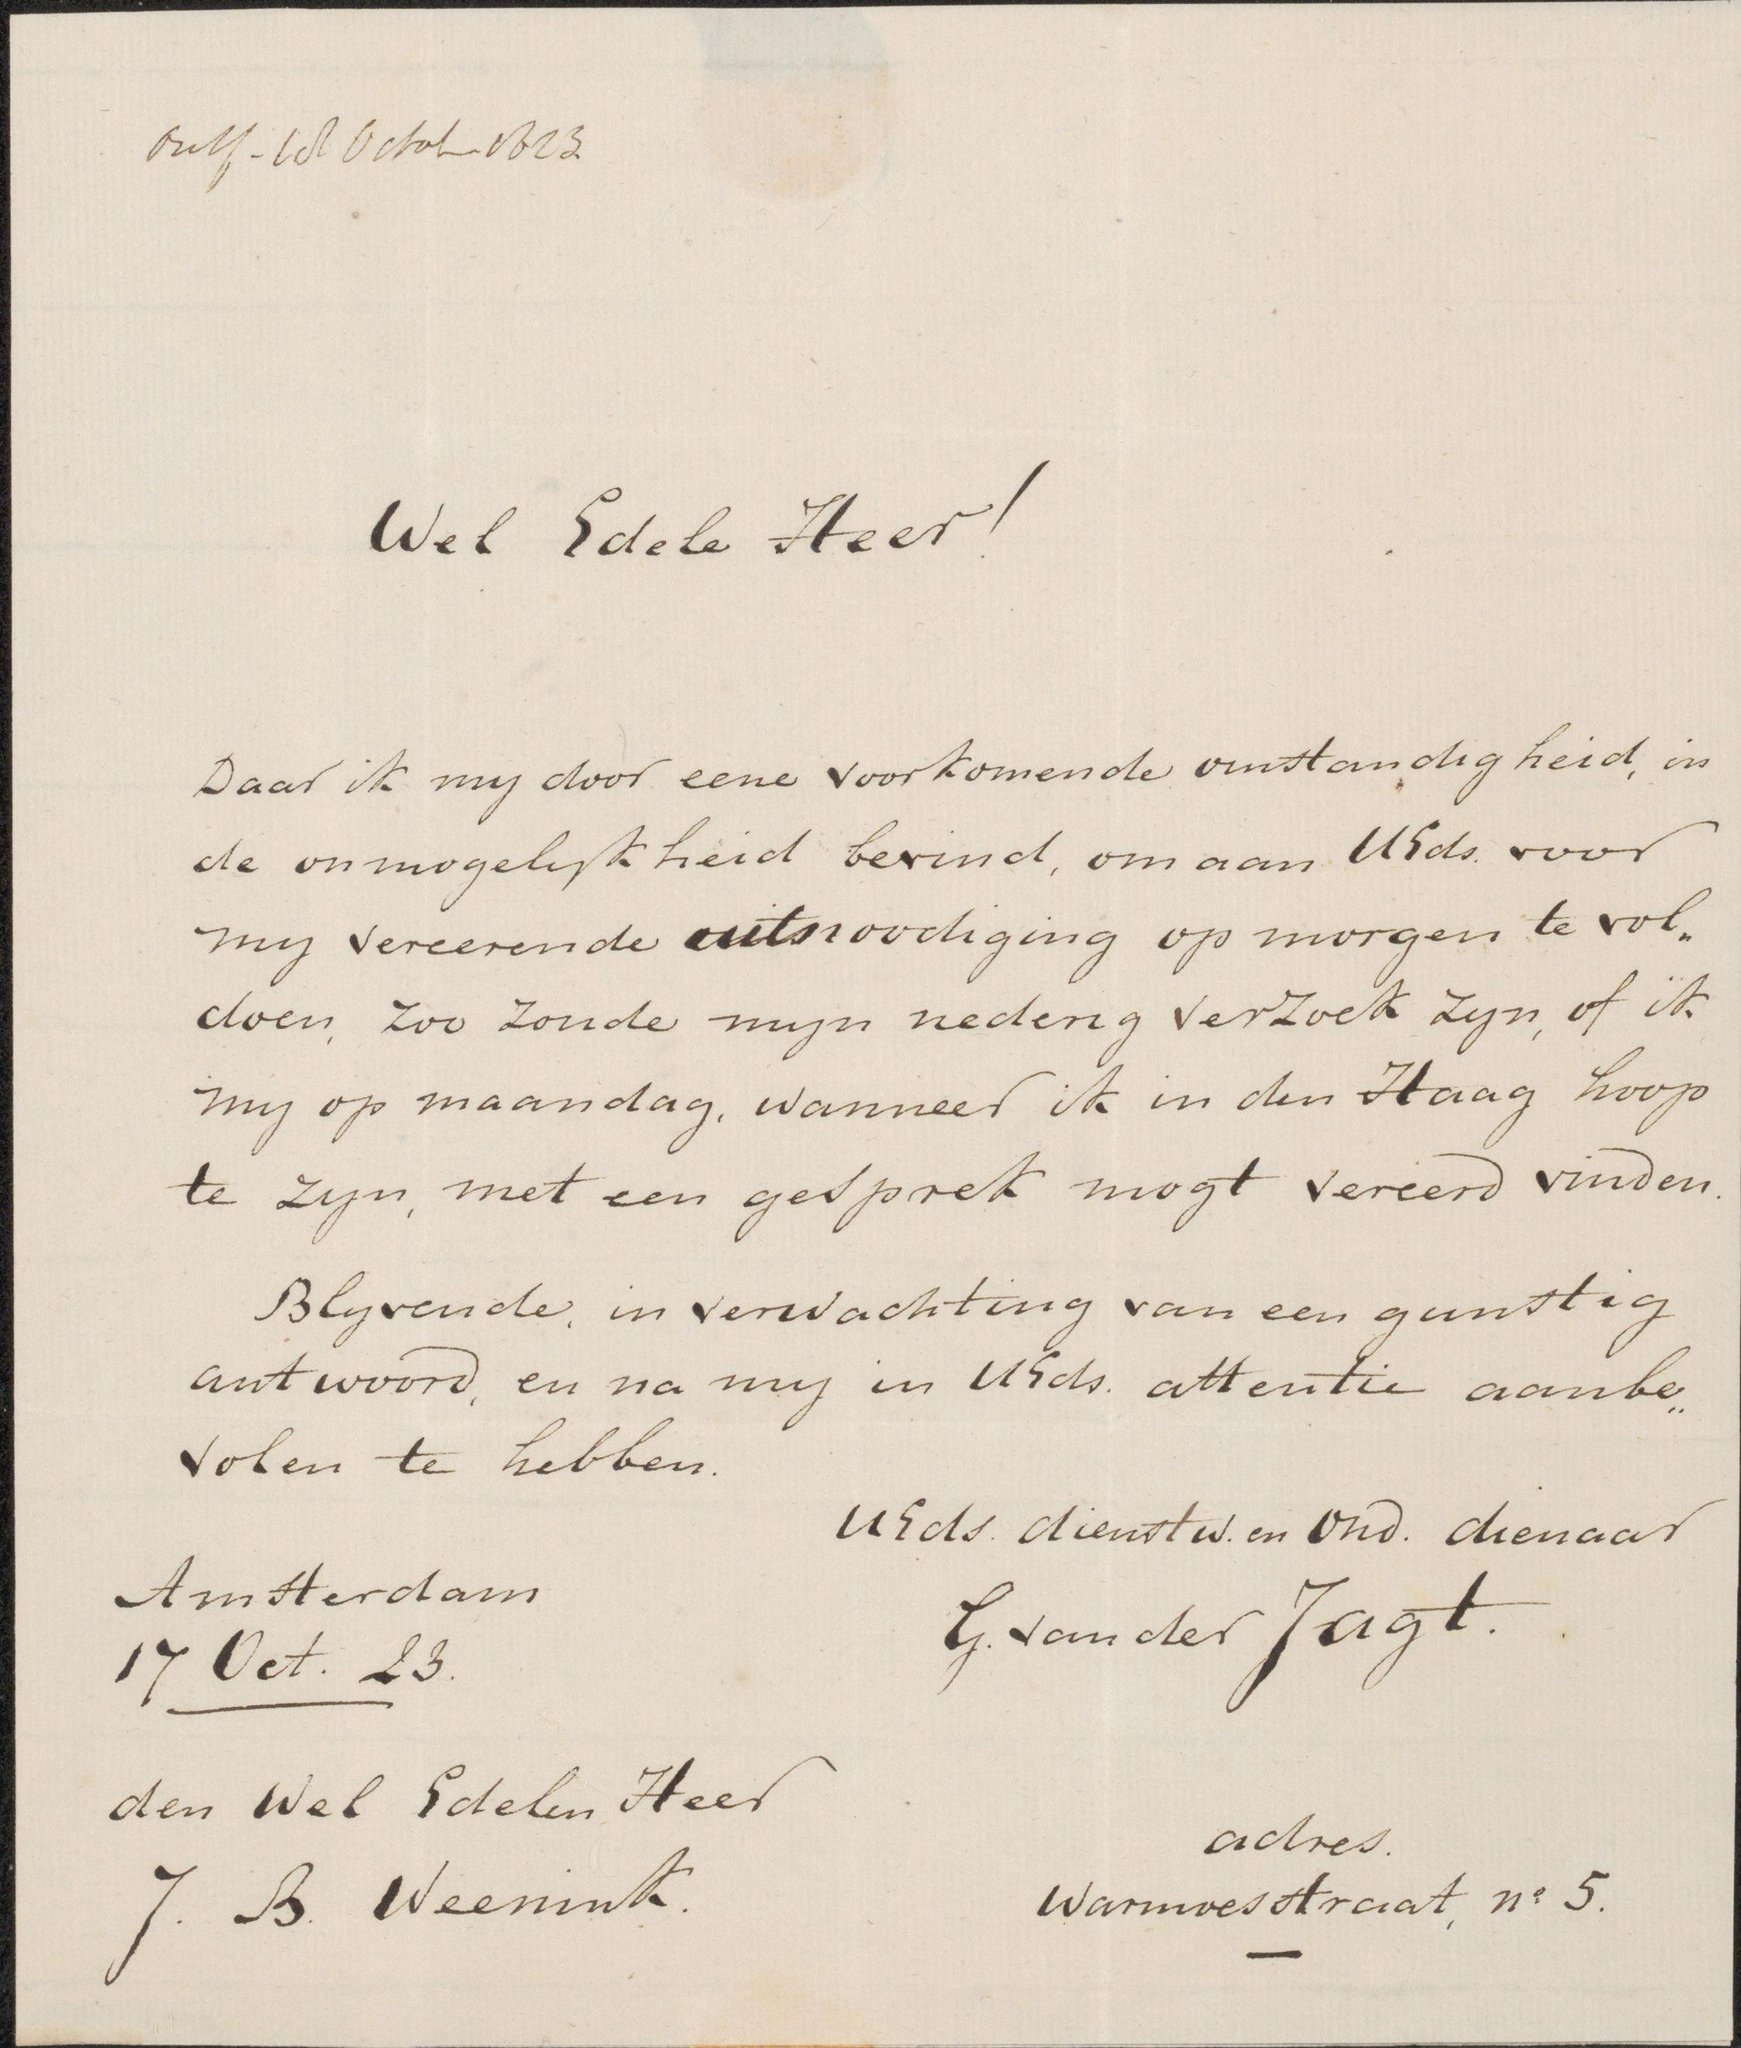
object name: letter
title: Brief aan Jean Baptiste Weenink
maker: gijsbert van der jagt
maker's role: directeur, onderwijzer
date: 1823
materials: ink, paper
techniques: pen, writing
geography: amsterdam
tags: paris, the hague, draughtsman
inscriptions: watermark